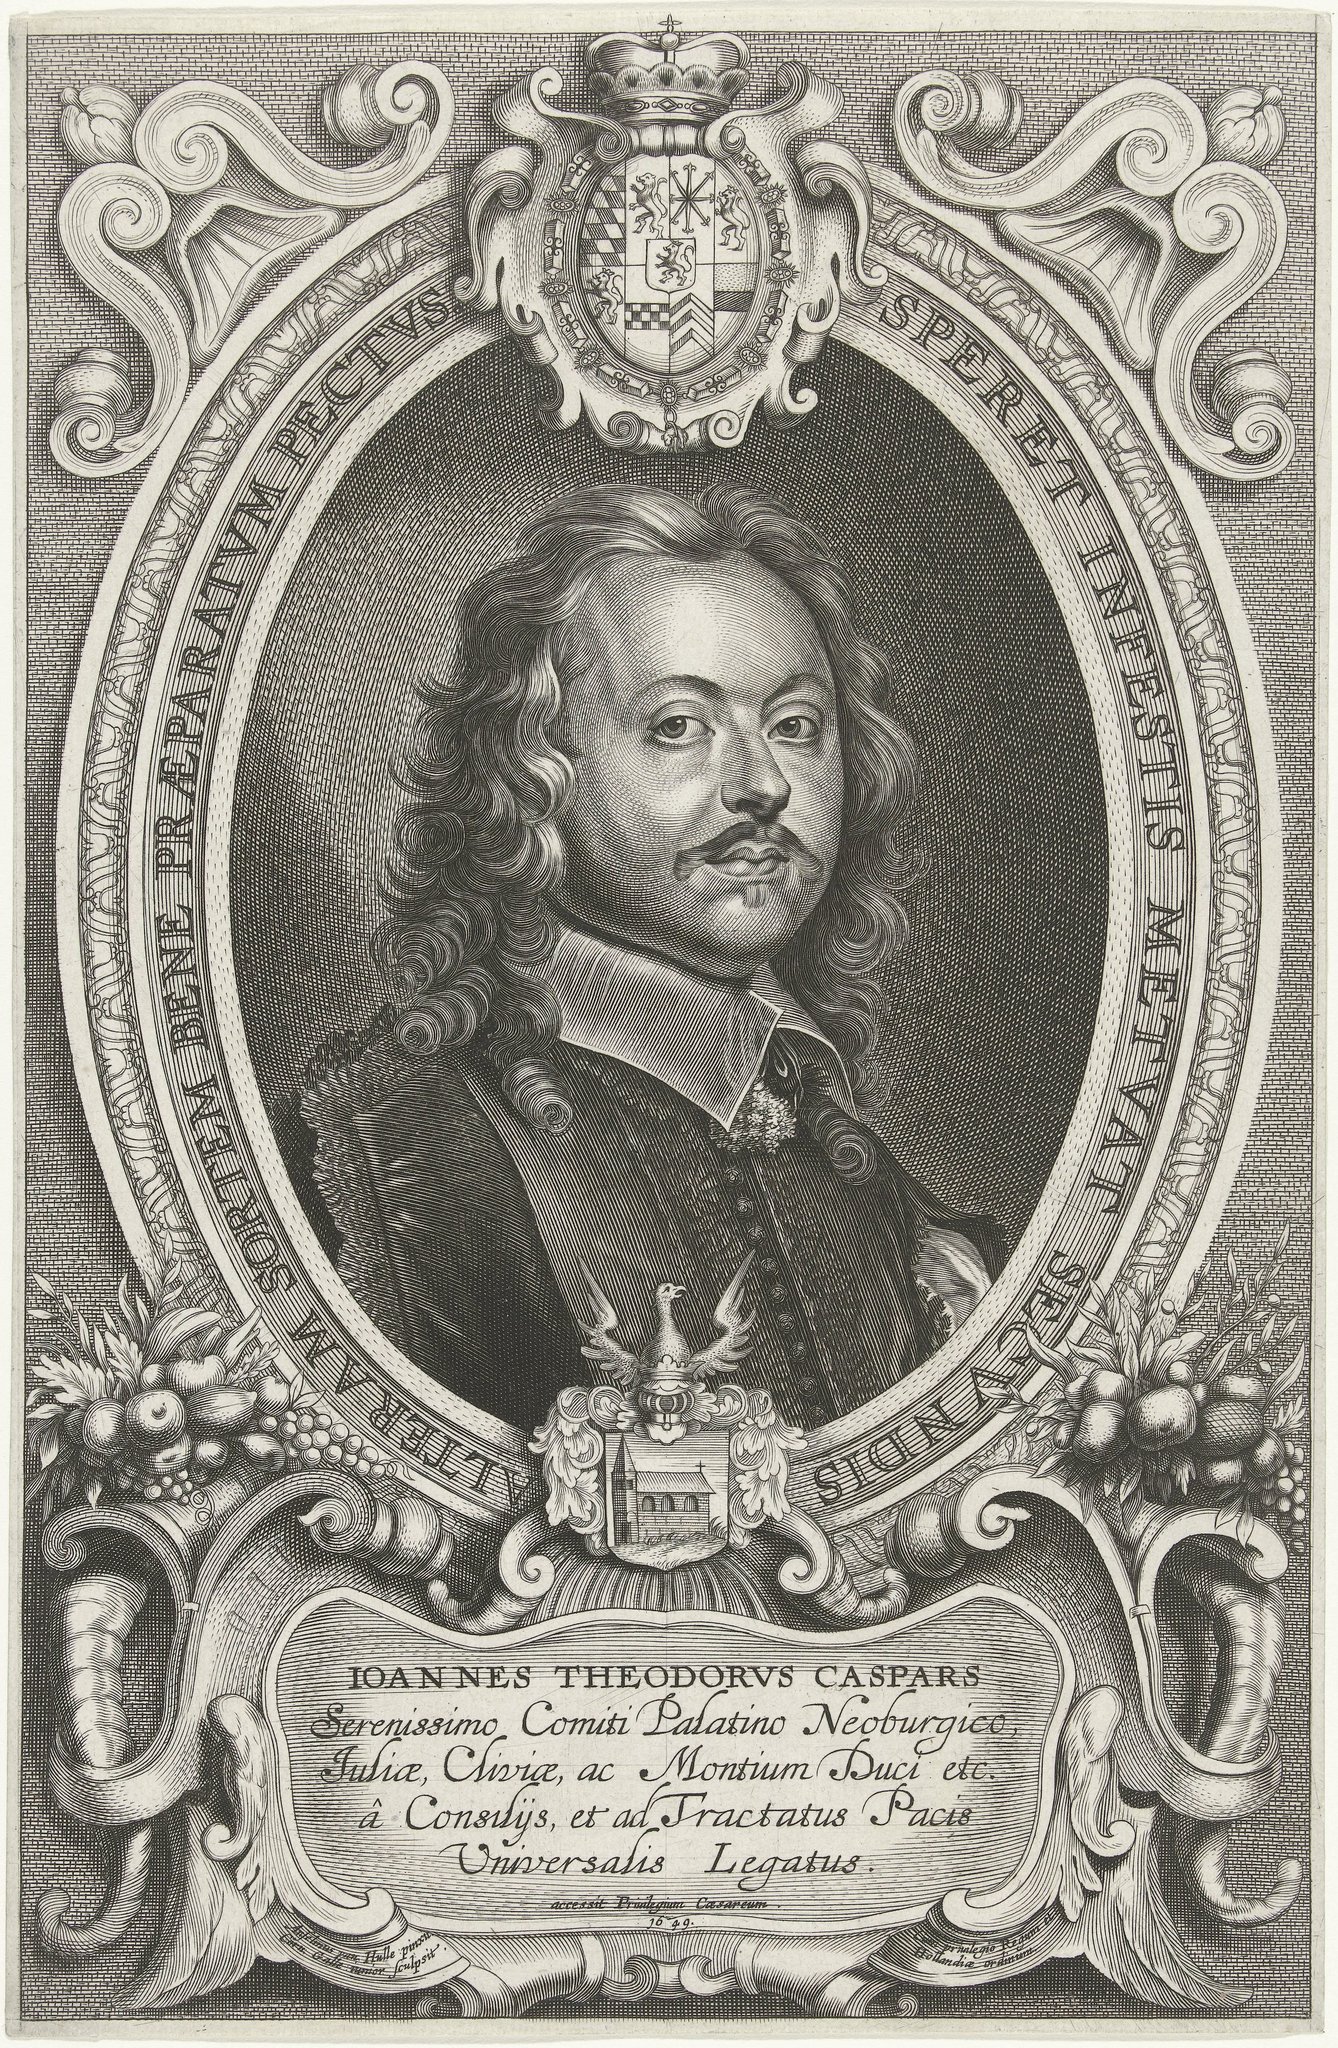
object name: print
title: Portret van Johann Theodor Caspars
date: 1649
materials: paper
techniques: engraving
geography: antwerp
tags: afgezant, johann theodor caspars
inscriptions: collector's mark: Lugt 2228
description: Portret van Johann Theodor Caspars afgezant tijdens de vredesonderhandelingen in Münster, in ovaal met randschrift en sierlijst. Boven en onder het portret twee wapens.